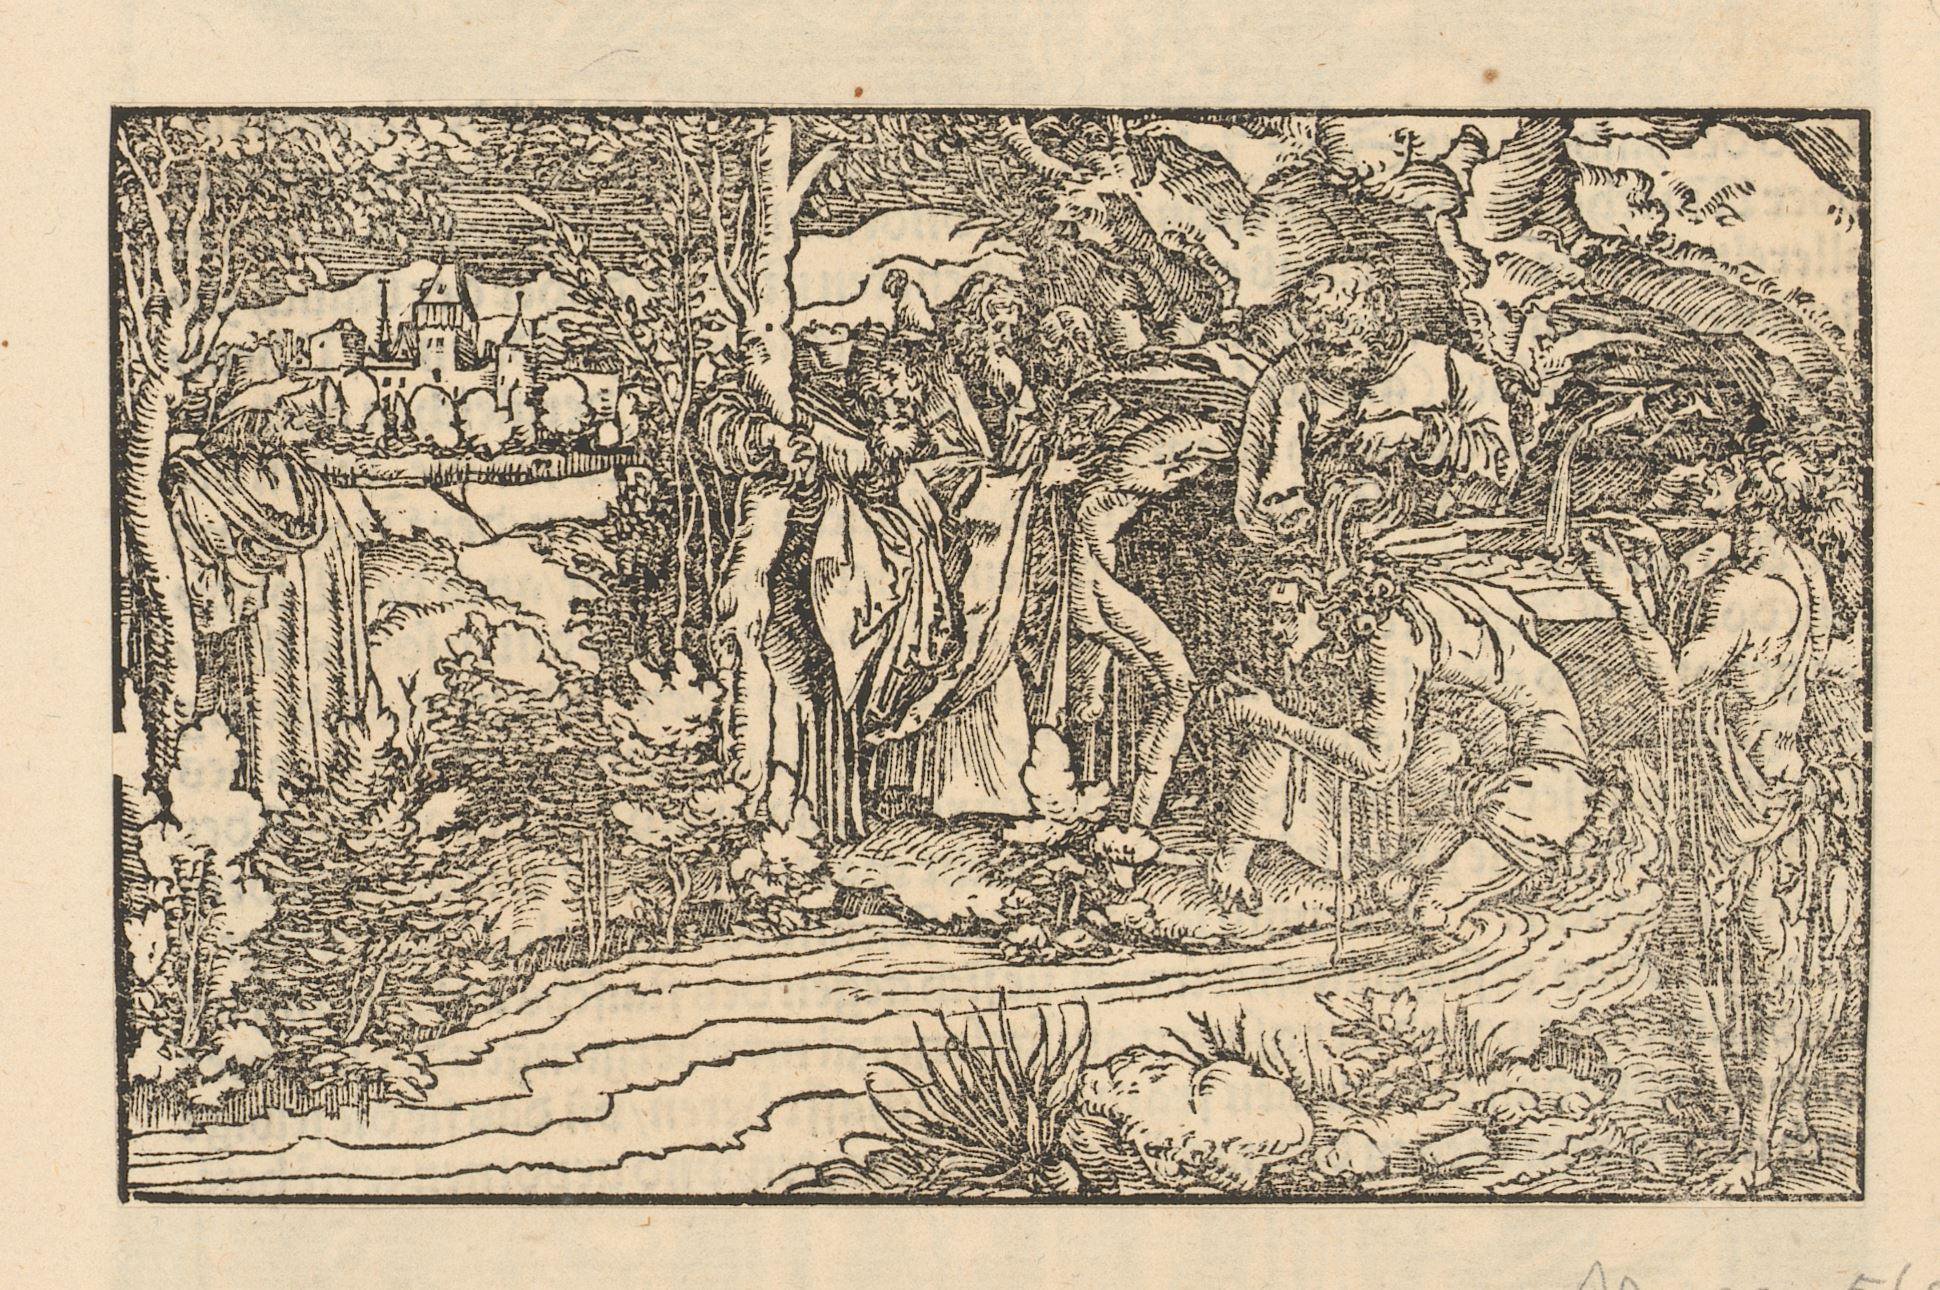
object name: book illustration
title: Cornelius de Honderdman gedoopt door H. Petrus in Caesarea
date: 1514-1531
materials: paper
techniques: letterpress printing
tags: peter and cornelius the centurion (acts 10)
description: Deze prent is gebruikt in: Cicero, Marcus Tulius. Officia M.T.C. Ein Buch so Marcus Tullius Cicero der Römer zu seynem (...). [Vertaald uit het Latijn door] Johann von Schwarzenberg. Augsburg: Heinrich Steiner, 1531.